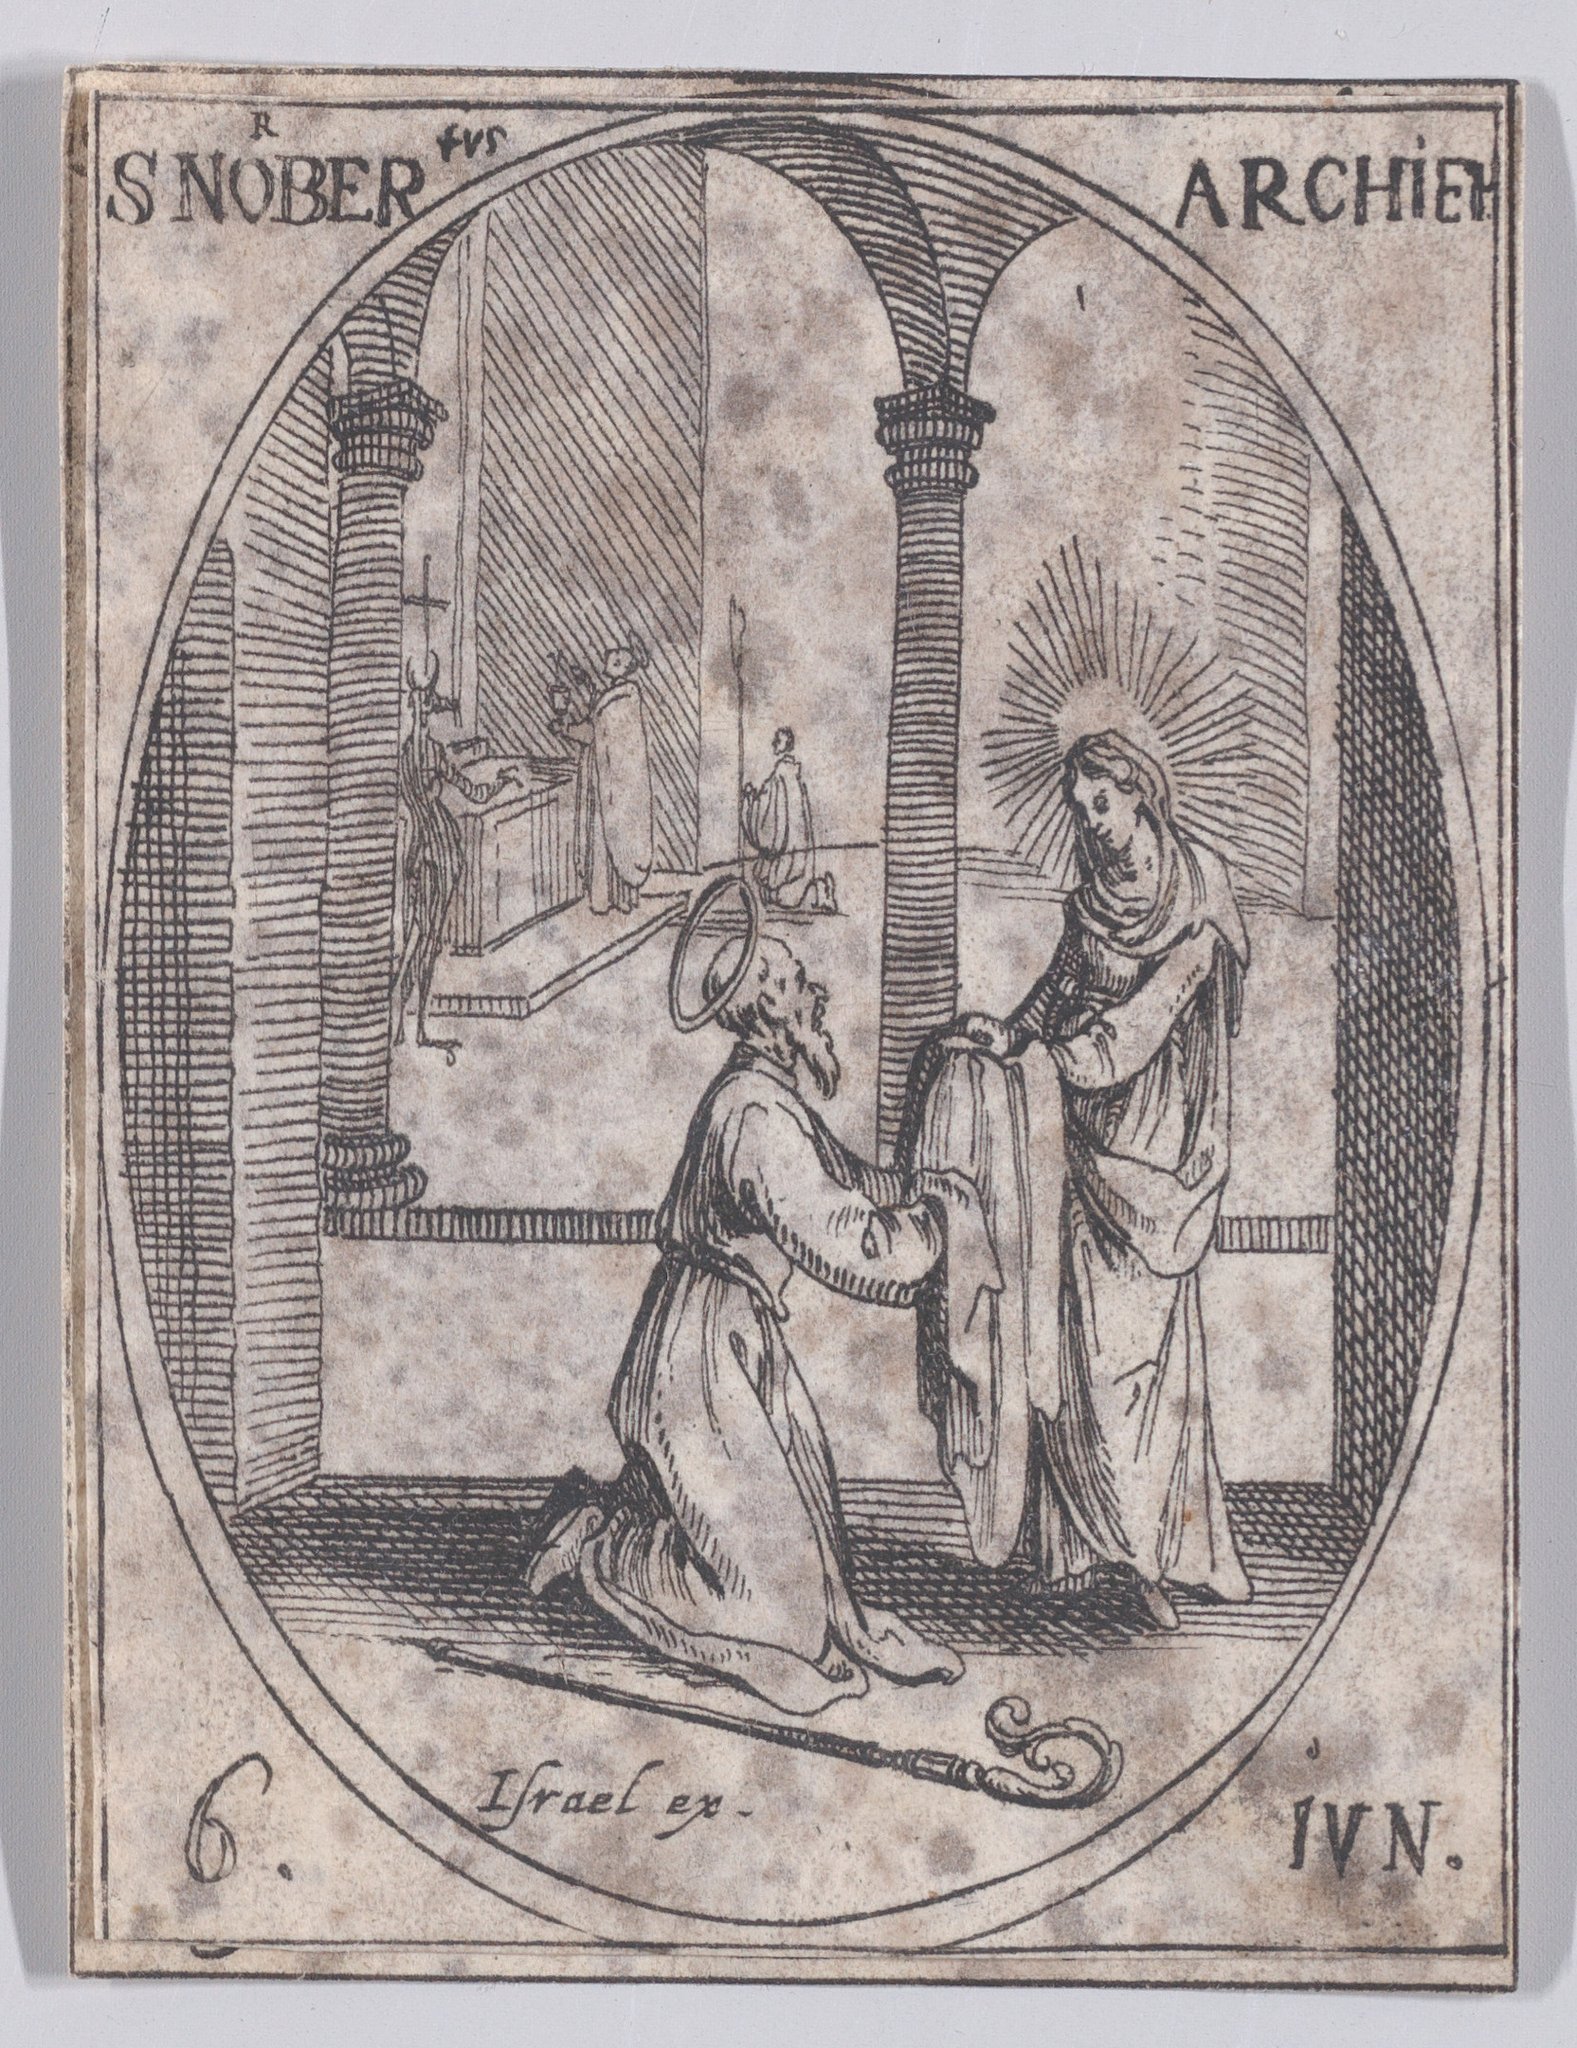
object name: print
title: S. Norbert, archevêque (St. Norbert, Archbishop), June 6th, from "Les Images De Tous Les Saincts et Saintes de L'Année" (Images of All of the Saints and Religious Events of the Year)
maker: jacques callot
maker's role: artist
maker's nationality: french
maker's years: 1592-1635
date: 1636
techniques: etching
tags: men,saints